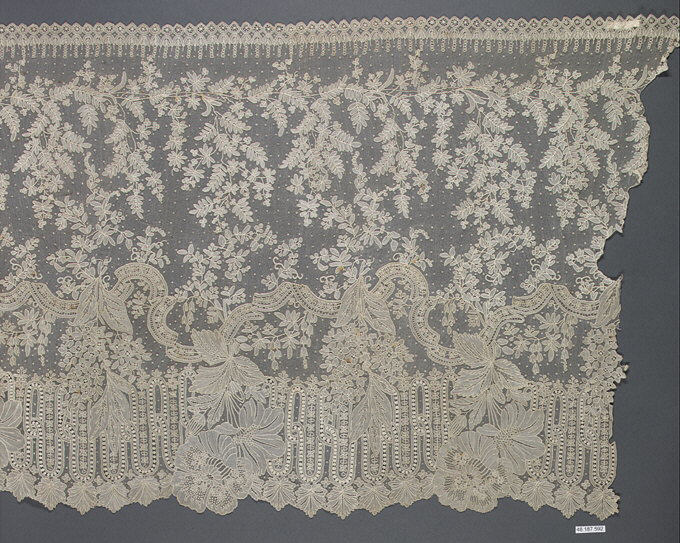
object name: flounce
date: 1851-1900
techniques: lace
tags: flowers